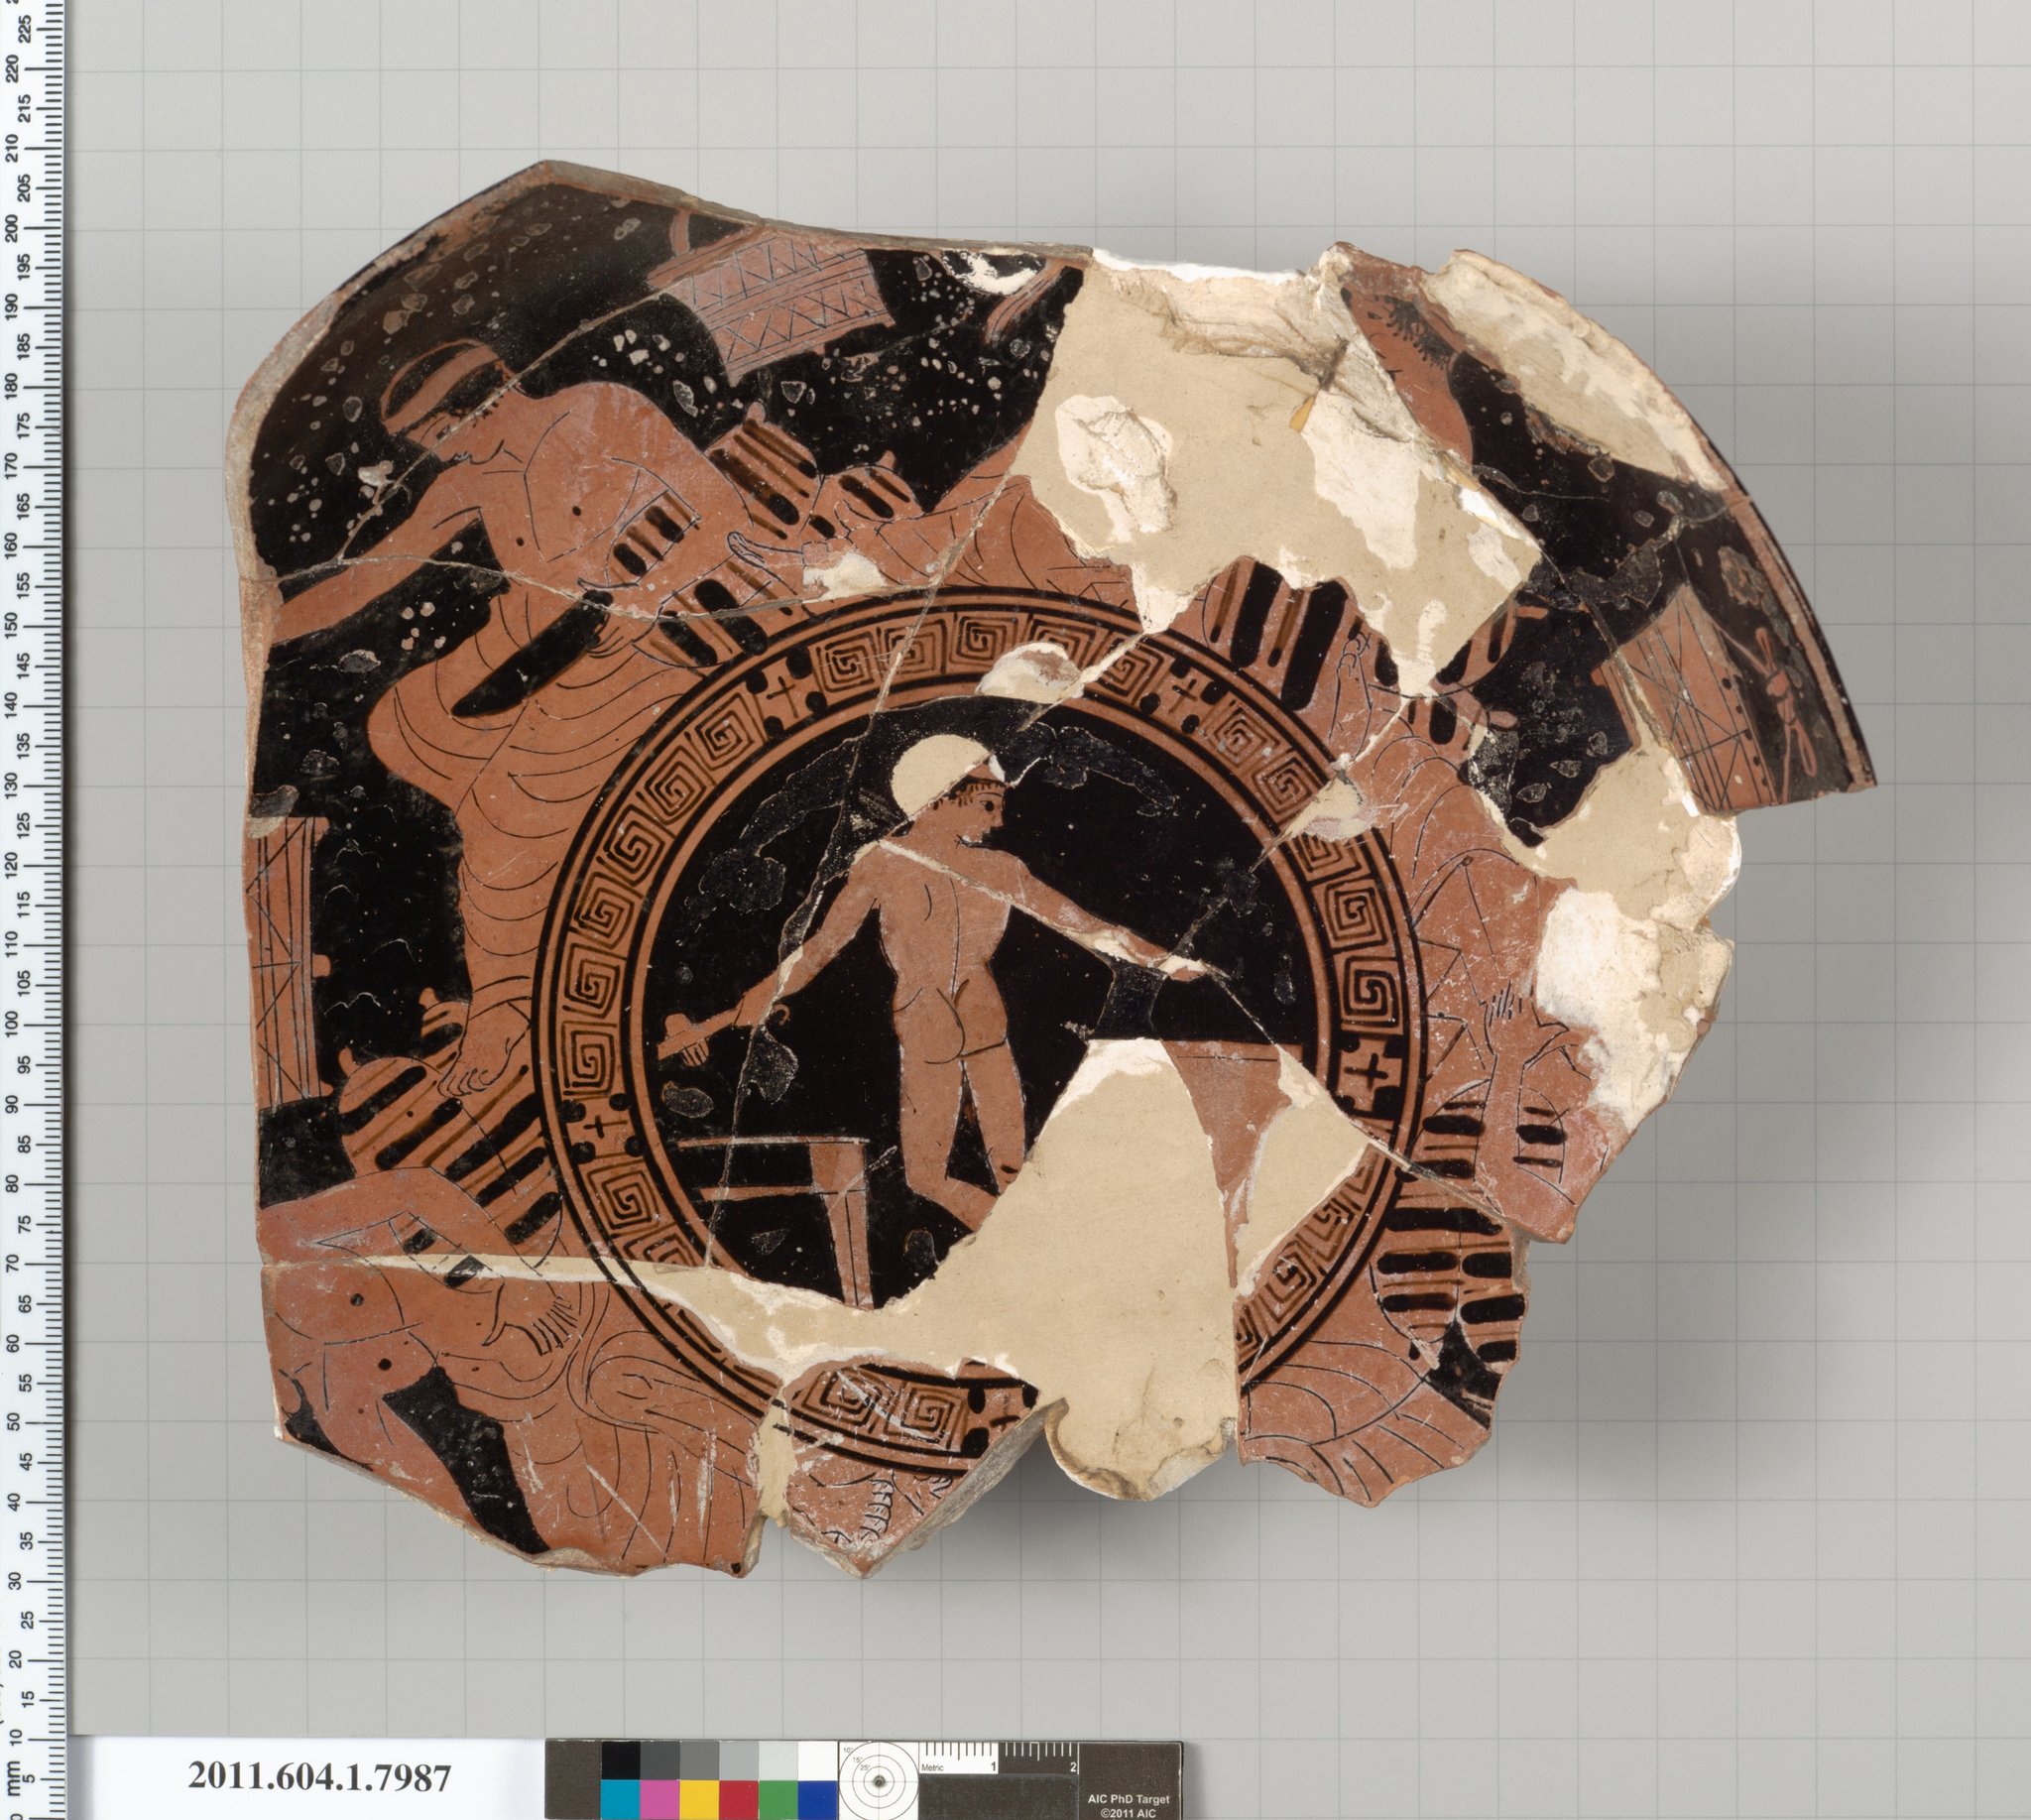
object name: kylix fragment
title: Terracotta fragment of a kylix (drinking cup)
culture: greek, attic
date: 460-450 BCE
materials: terracotta